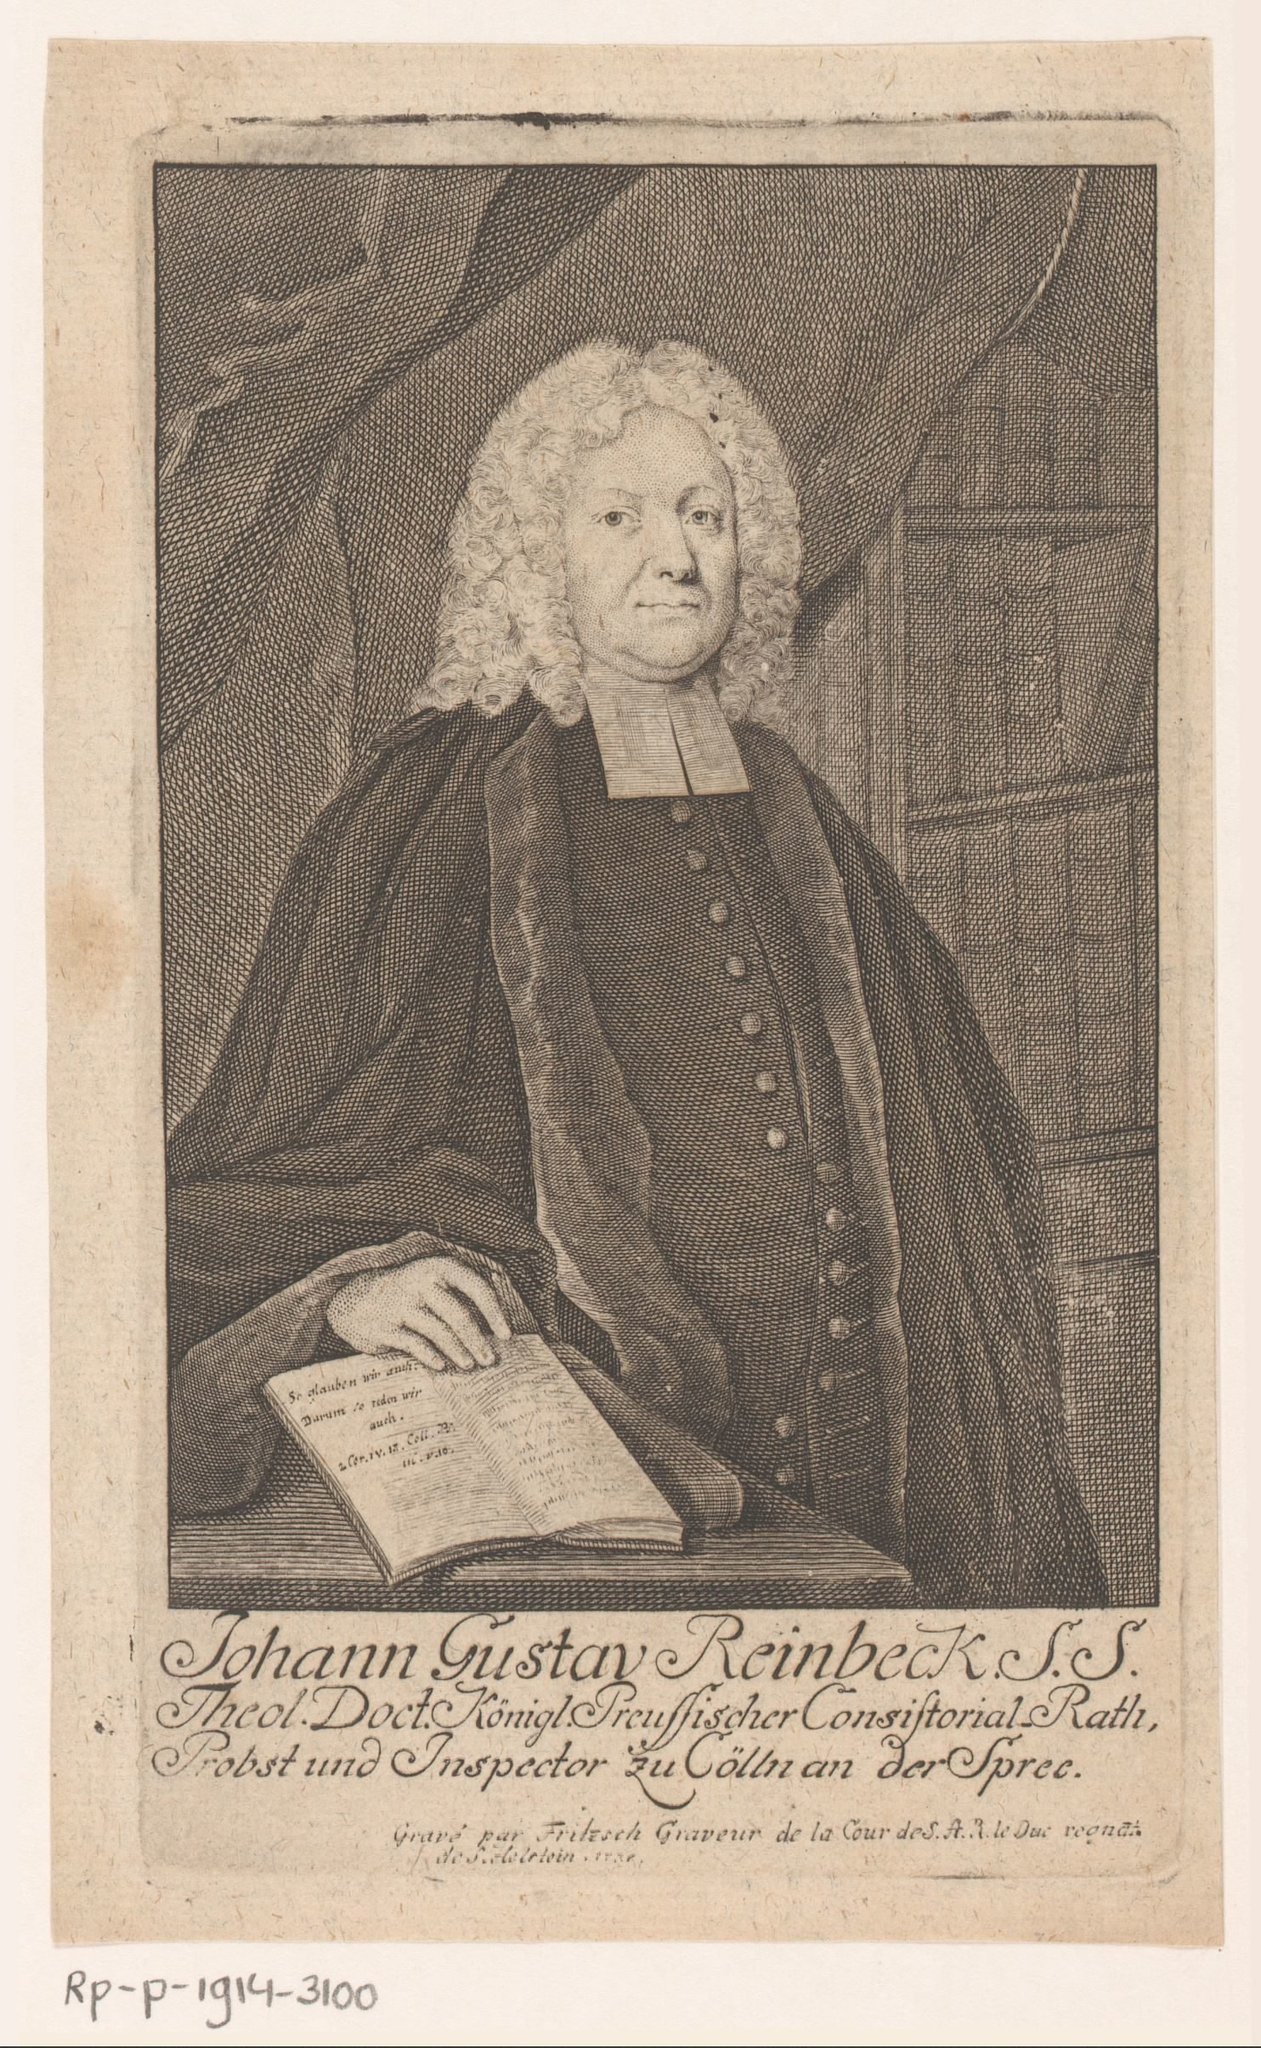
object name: print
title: Portret van Johann Gustav Reinbeck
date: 1731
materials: paper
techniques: engraving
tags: bookshelves, theologian, historical persons, book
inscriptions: collector's mark: Lugt 2228